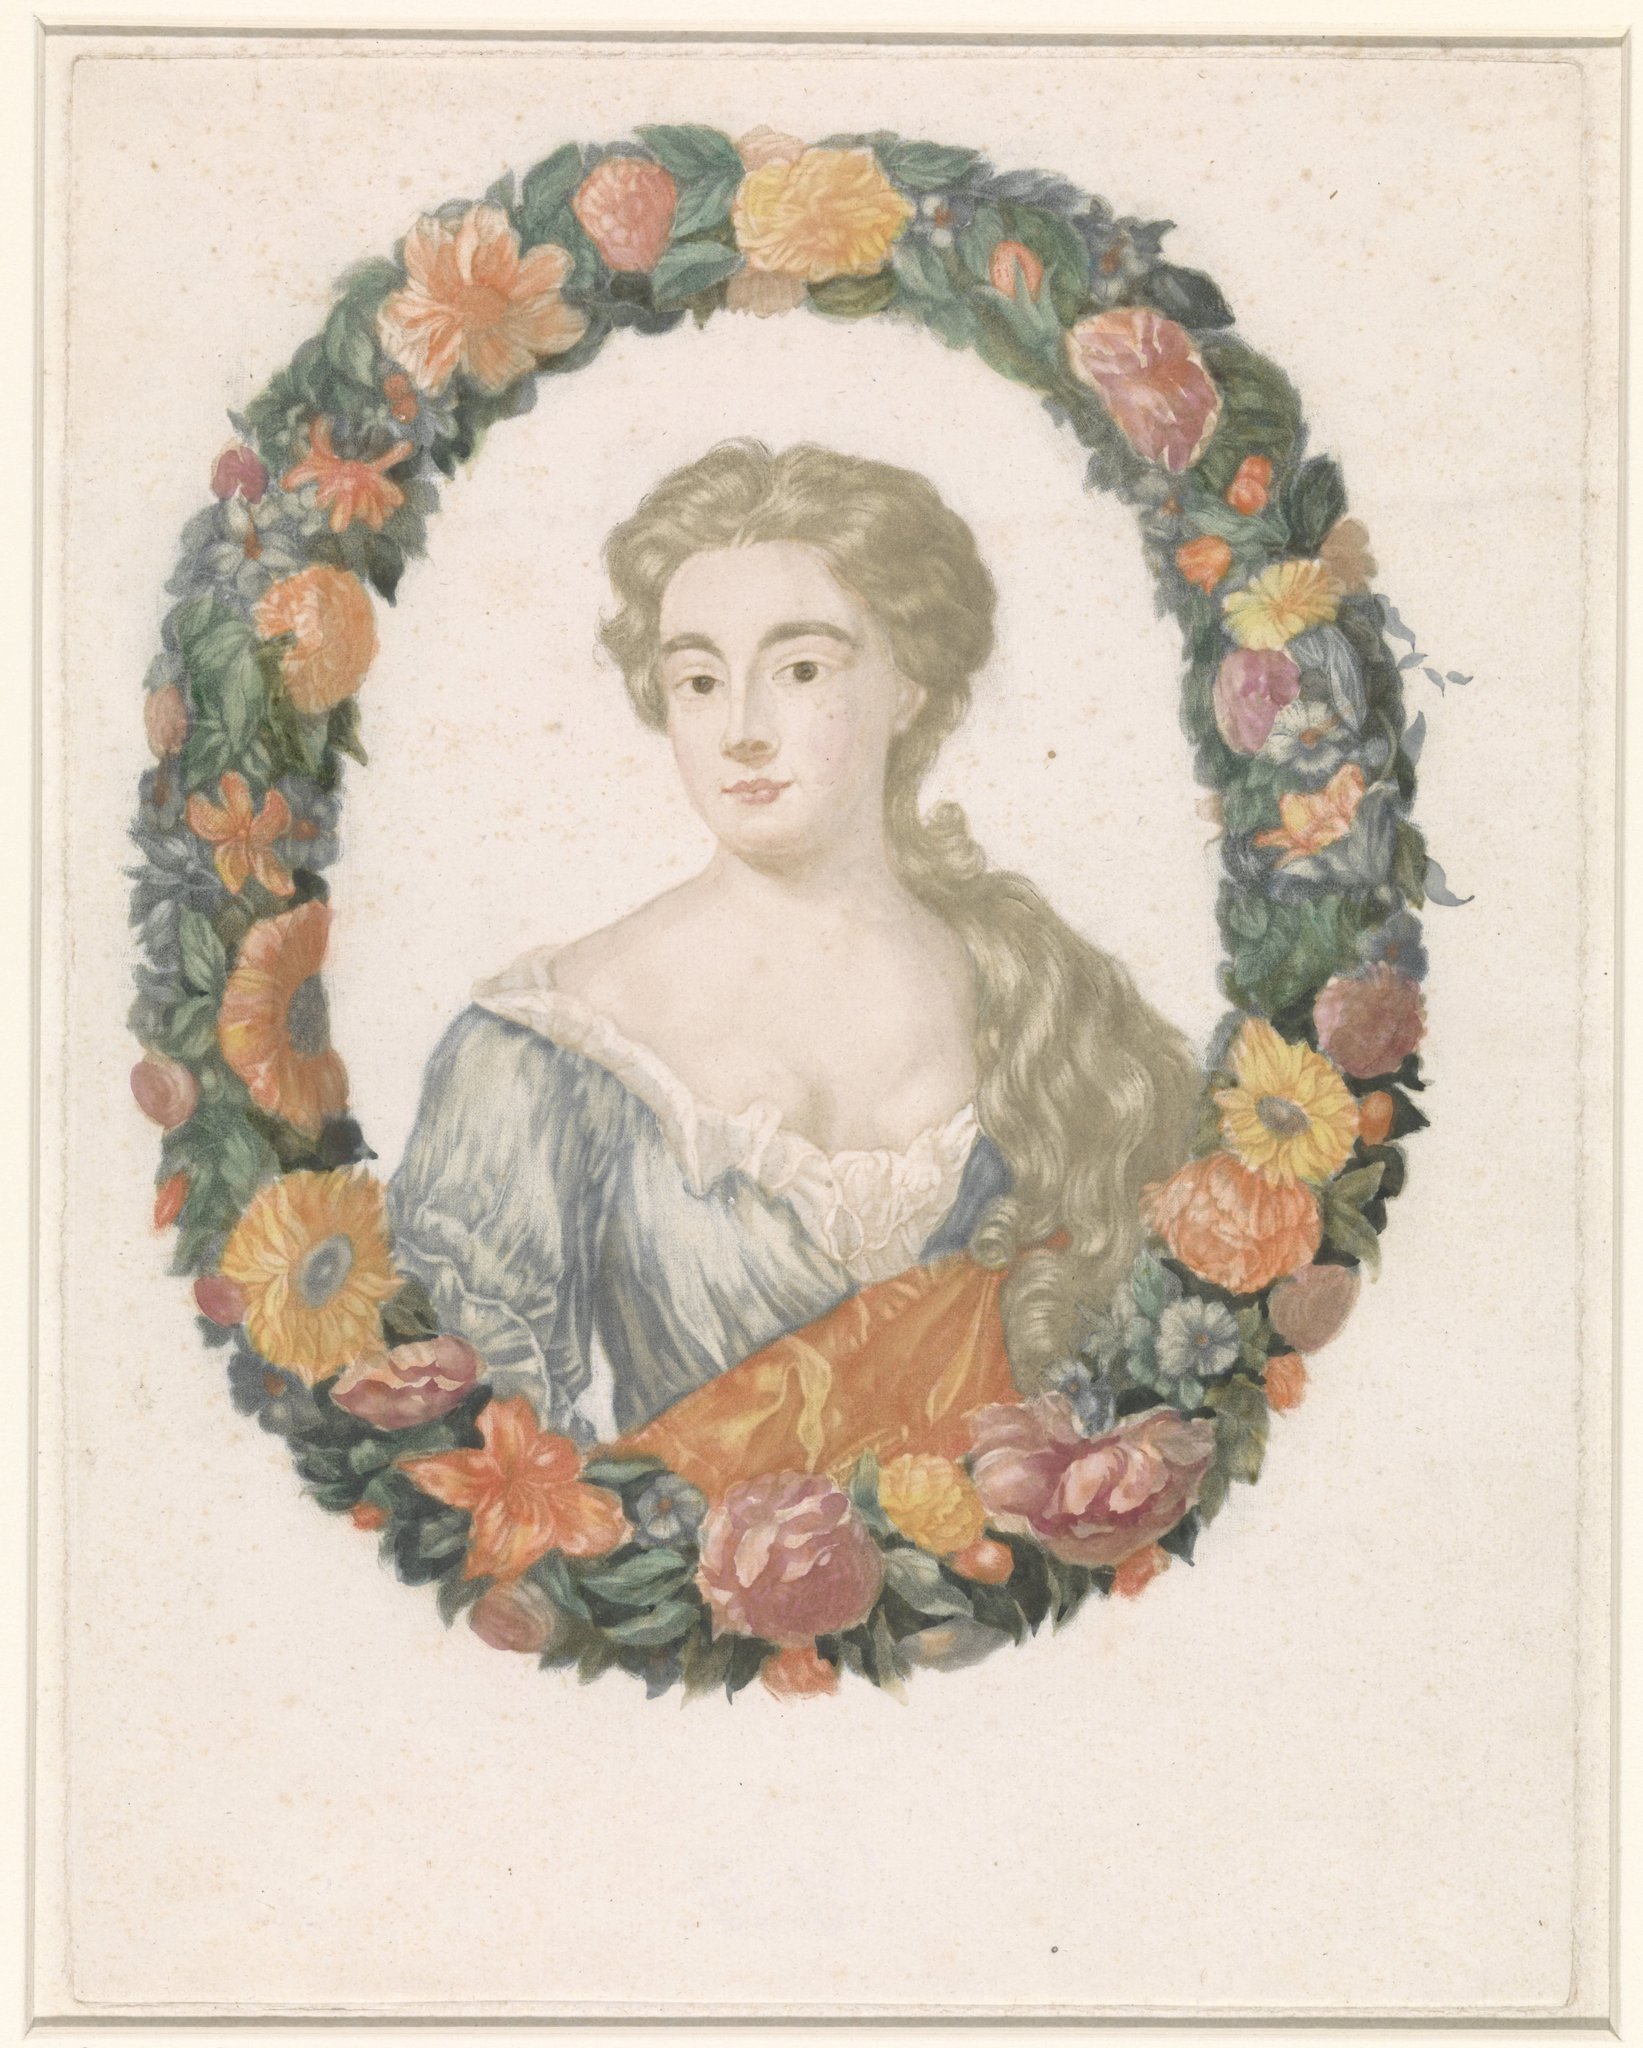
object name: print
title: Portret van een vrouw in bloemenkrans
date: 1688-1698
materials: paper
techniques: printing, lithography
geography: netherlands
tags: flowers, adult woman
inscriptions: collector's mark: Lugt 2760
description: Portret van een vrouw gevat in een ovale bloemenkrans.